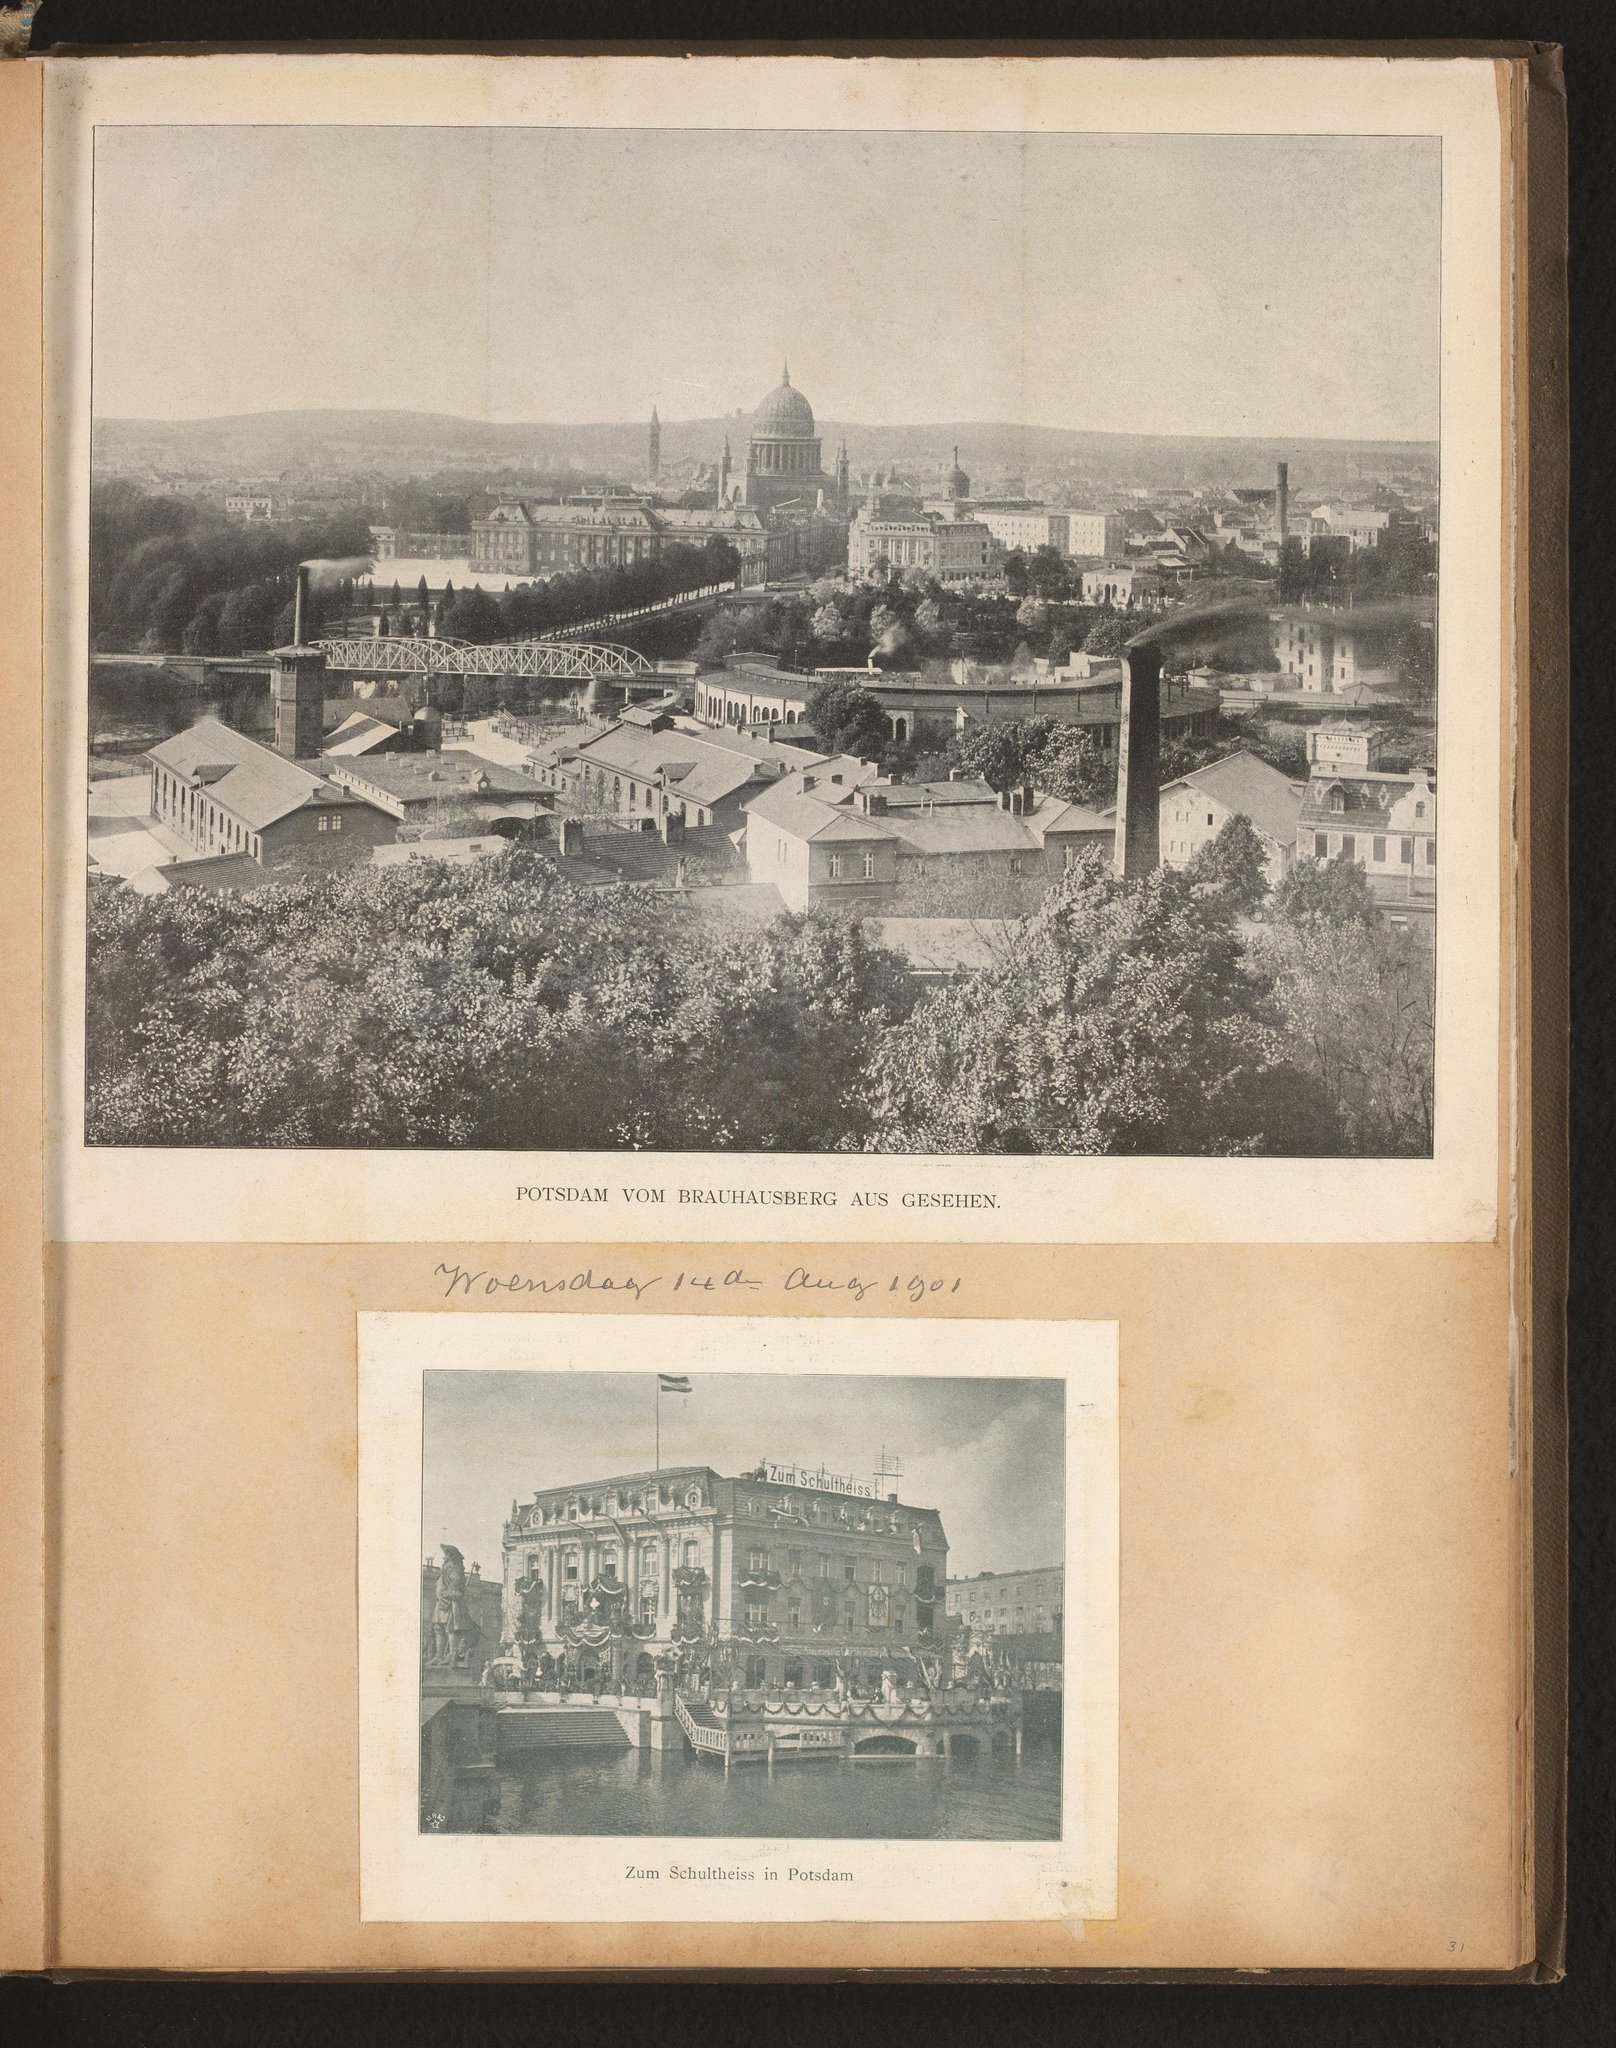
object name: album leaf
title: Gezicht op Potsdam en restaurant Zum Schultheiss, Potsdam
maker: Anonymous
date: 1896-1901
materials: paper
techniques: autotype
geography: schöneberg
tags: city-view in general; 'veduta', hotel, hostelry, inn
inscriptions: title: ‘Potsdam vom Brauhausberg aus gesehen.’, inscription: ‘Zum Schultheiss in Potsdam.’, inscription: ‘Woensdag 14de Aug 1901’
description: Deze fotomechanische afdrukken maken deel uit van een album.